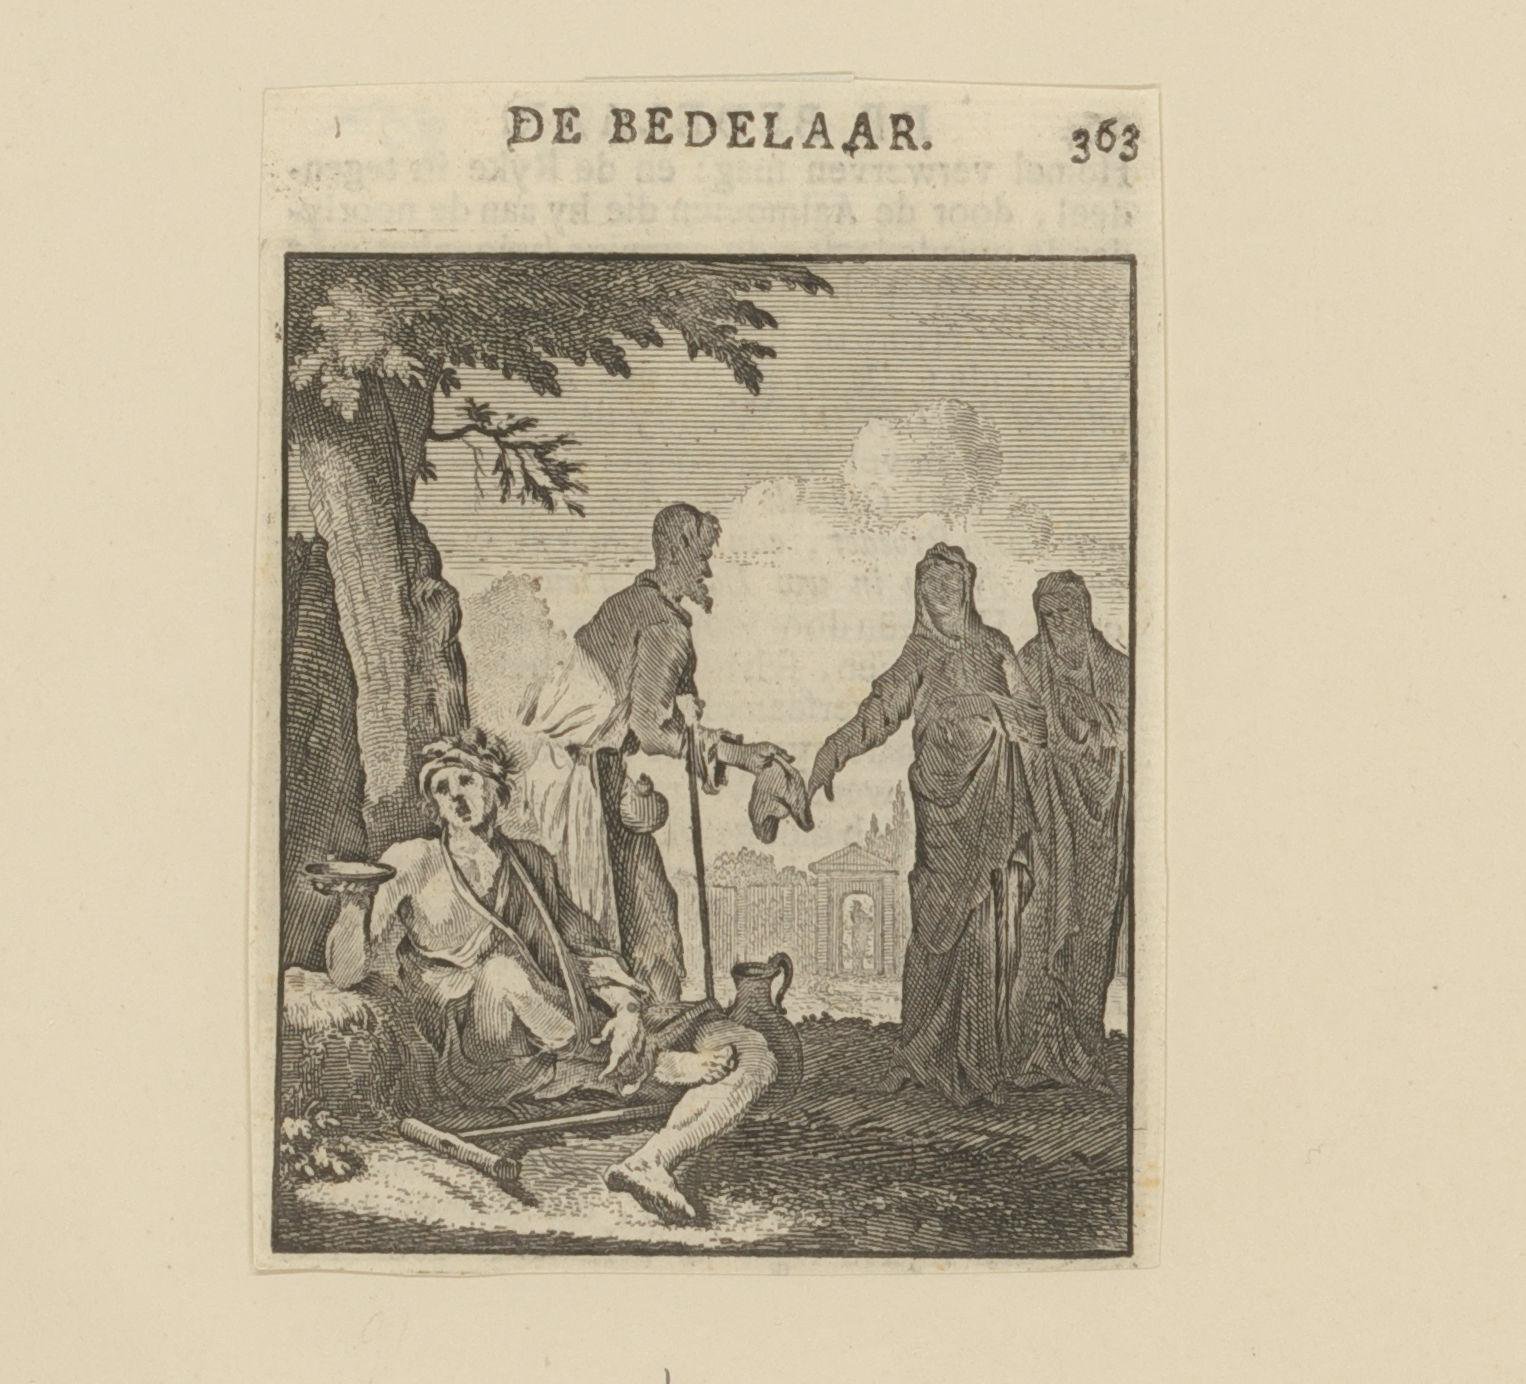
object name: print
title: De Bedelaar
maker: Anonymous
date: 1719-1759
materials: paper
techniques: etching, letterpress printing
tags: beggar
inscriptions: collector's mark: Lugt 1641, stamp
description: Prent met andere letterzetting gebruikt in: St. Clara, Abraham van. Iets voor allen. [Vertaald door] J. le Long. Amsterdam: Janssoons van Waesberge, 1719, dl. 2. En in: St. Clara, Abraham van. Iets voor allen. [Vertaald door] J. le Long. Amsterdam: Jan Roman de Jonge, 1741, dl. 2. En in: St. Clara, Abraham van. Iets voor allen. [Vertaald door] J. le Long. Amsterdam: Jan Roman, 1759, dl. 2. Huidige prent uit een andere editie. Naar een prent van: Jan Luyken.